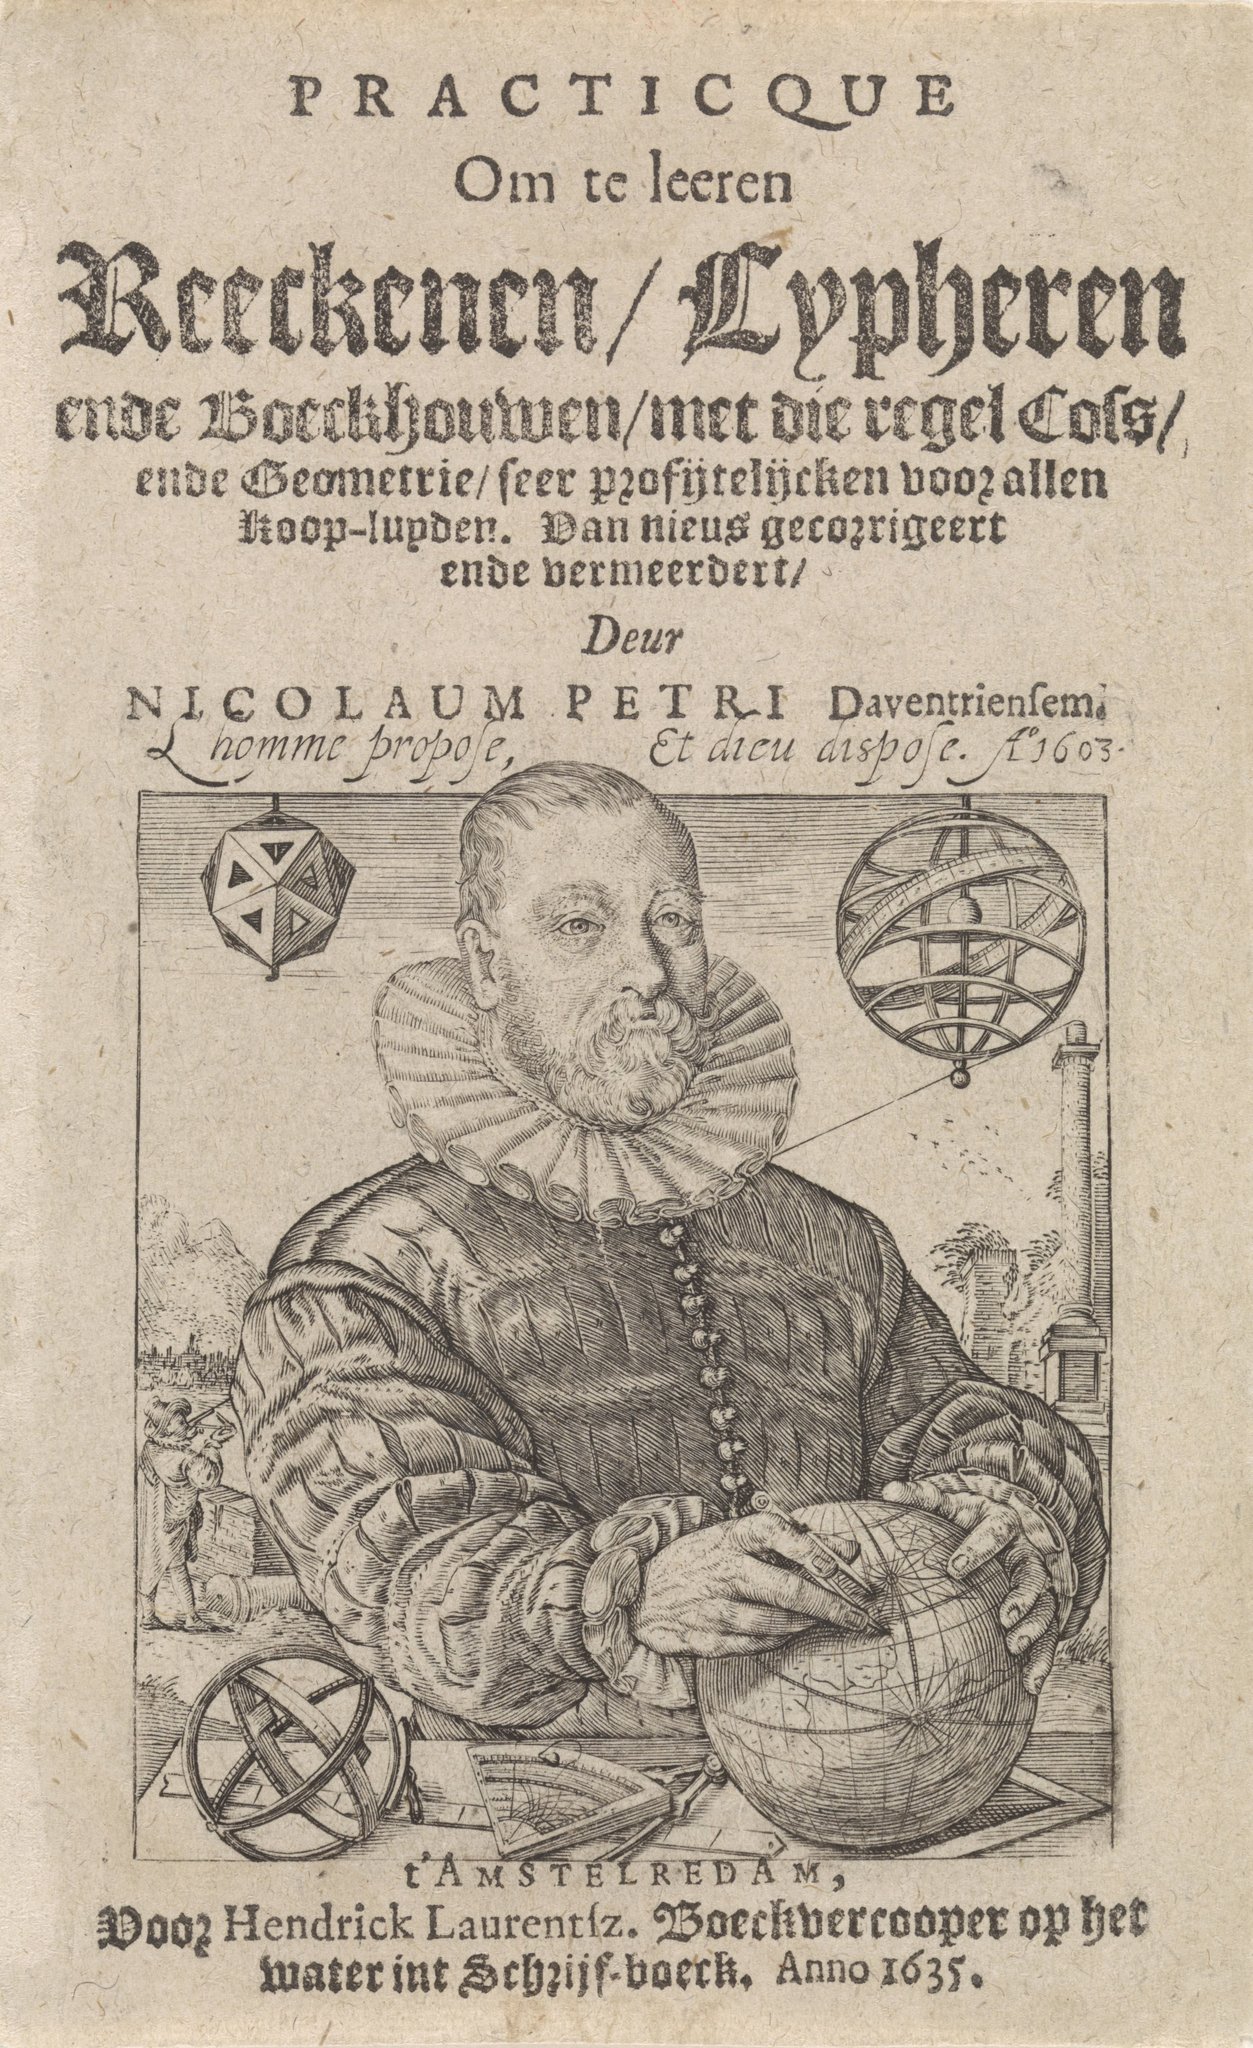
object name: print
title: Titelpagina voor: N. Petri. Practicqve, om te leeren rekenen, cypheren ende boeckhouden, 1635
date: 1635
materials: paper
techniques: engraving, letterpress printing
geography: amsterdam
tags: measuring-instruments, armillary sphere, skeleton celestial globe, globe, globe in the shape of an icosahedron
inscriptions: collector's mark: Lugt 2228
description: Portret van Nicolaus Petri [van Deventer], rekenmeester en astronoom in Amsterdam. Portret ten halven lijve, achter een tafel waarop mathematische en astronomische instrumenten: globe, hemelsfeer, astrolabium, passer. Rechts van zijn hoofd een hemelsfeer en links een icosahedron. Op de achtergrond richt een man een meetinstrument op een obelisk.